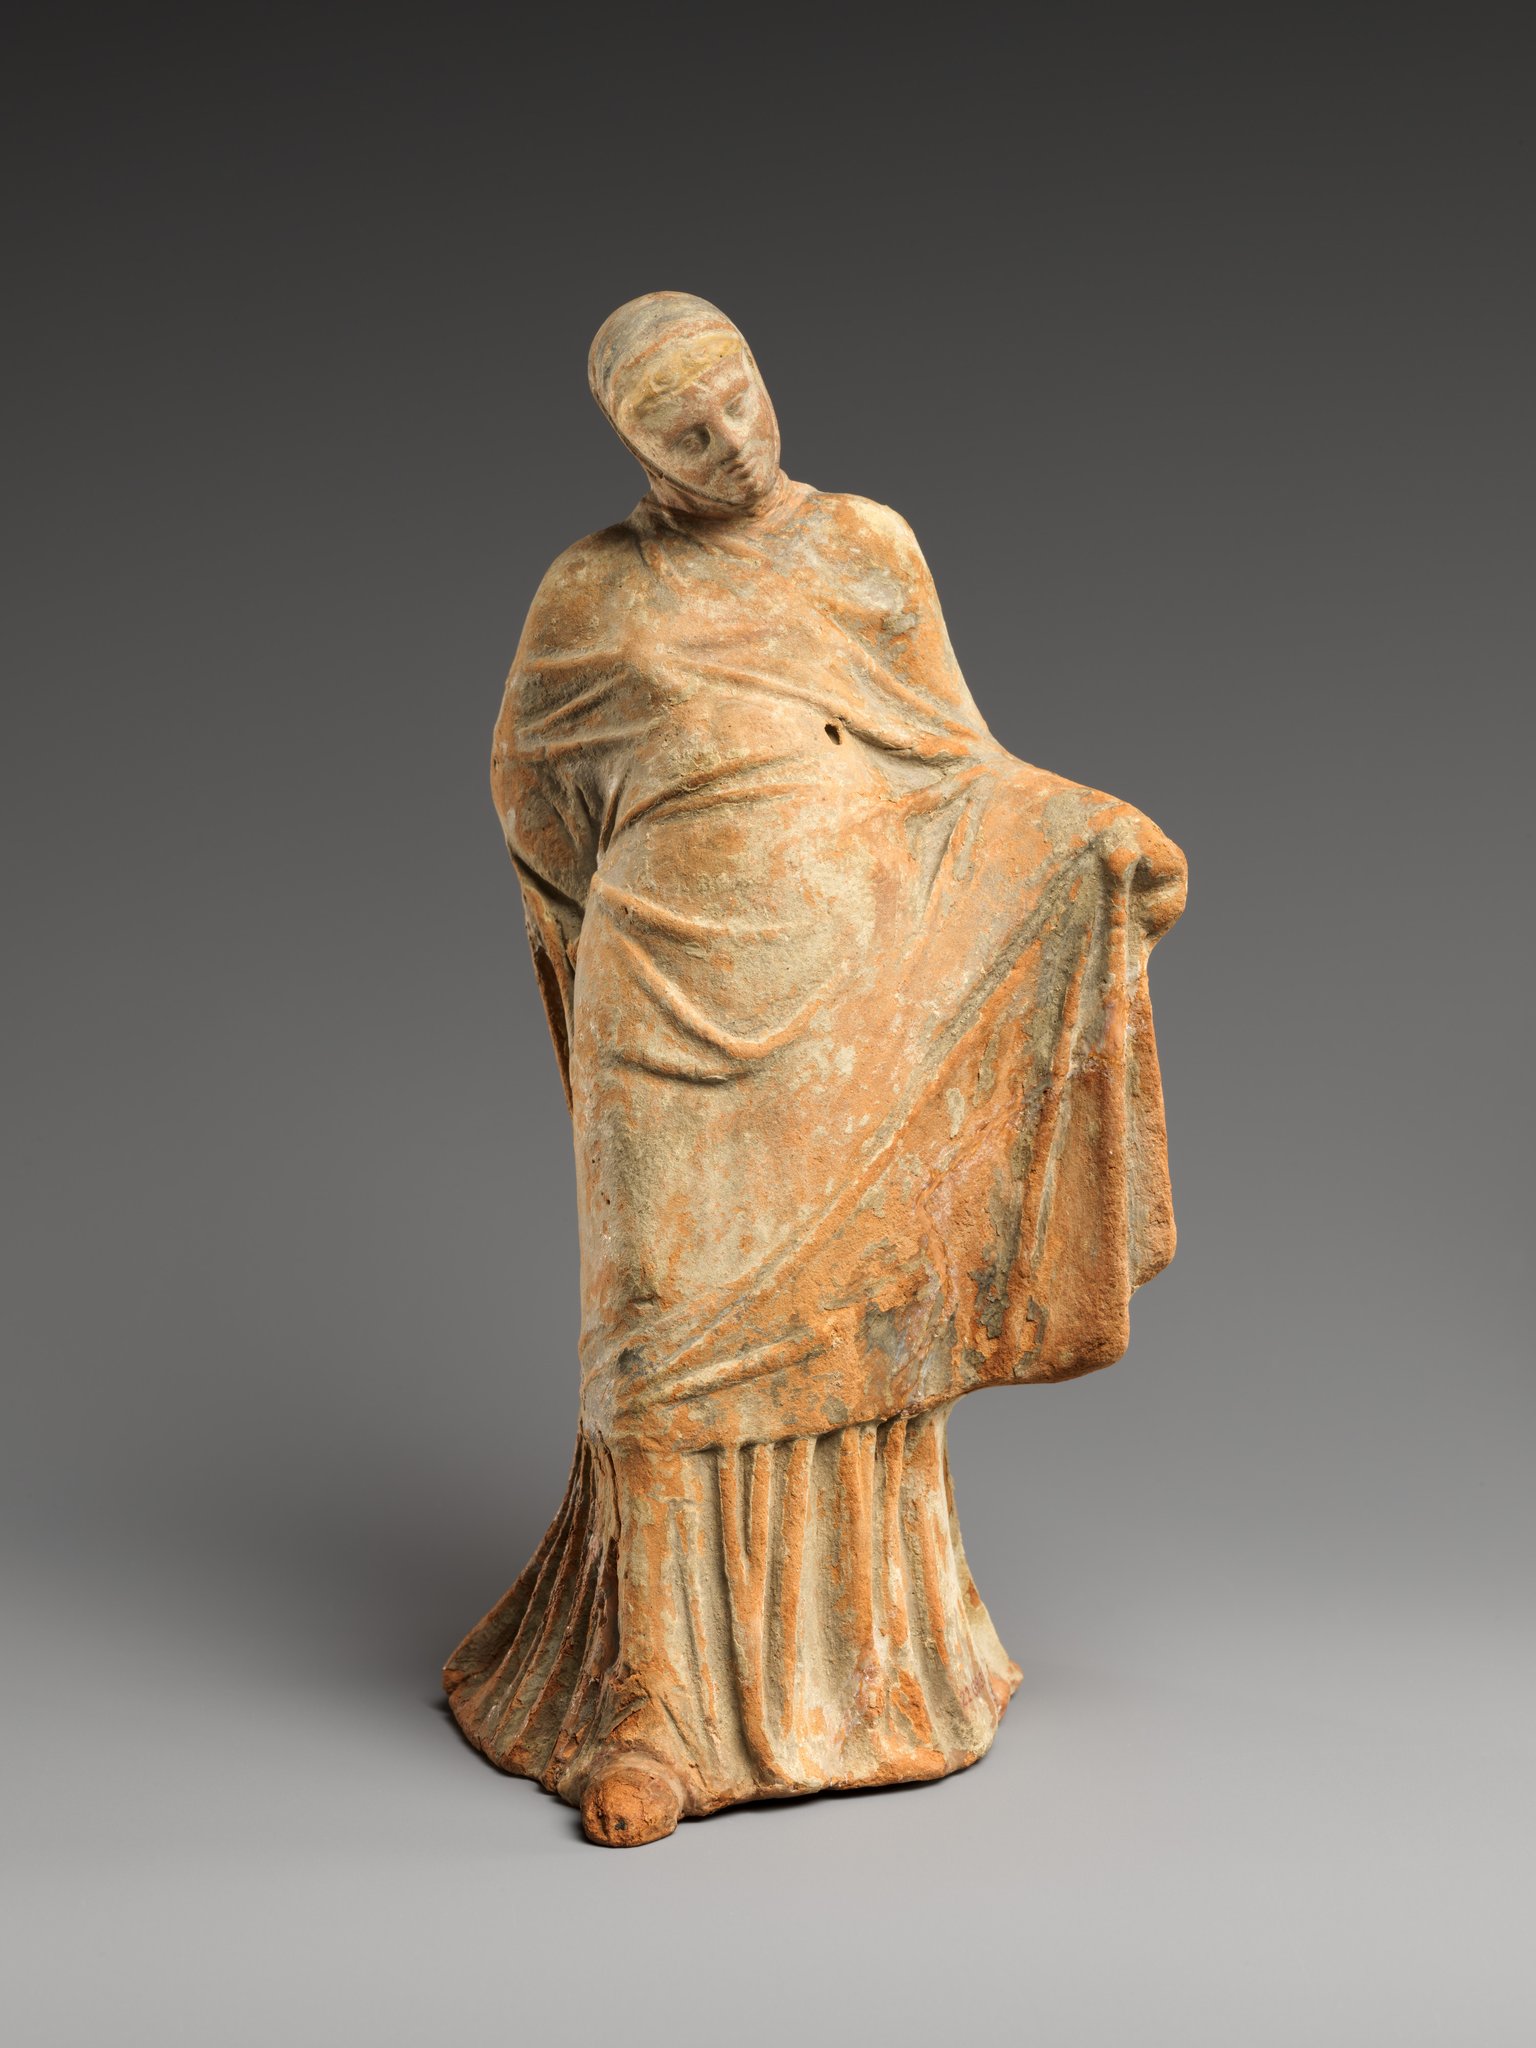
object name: statuette of a woman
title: Terracotta statuette of a veiled dancer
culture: greek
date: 300-201 BCE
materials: terracotta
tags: women,dancers